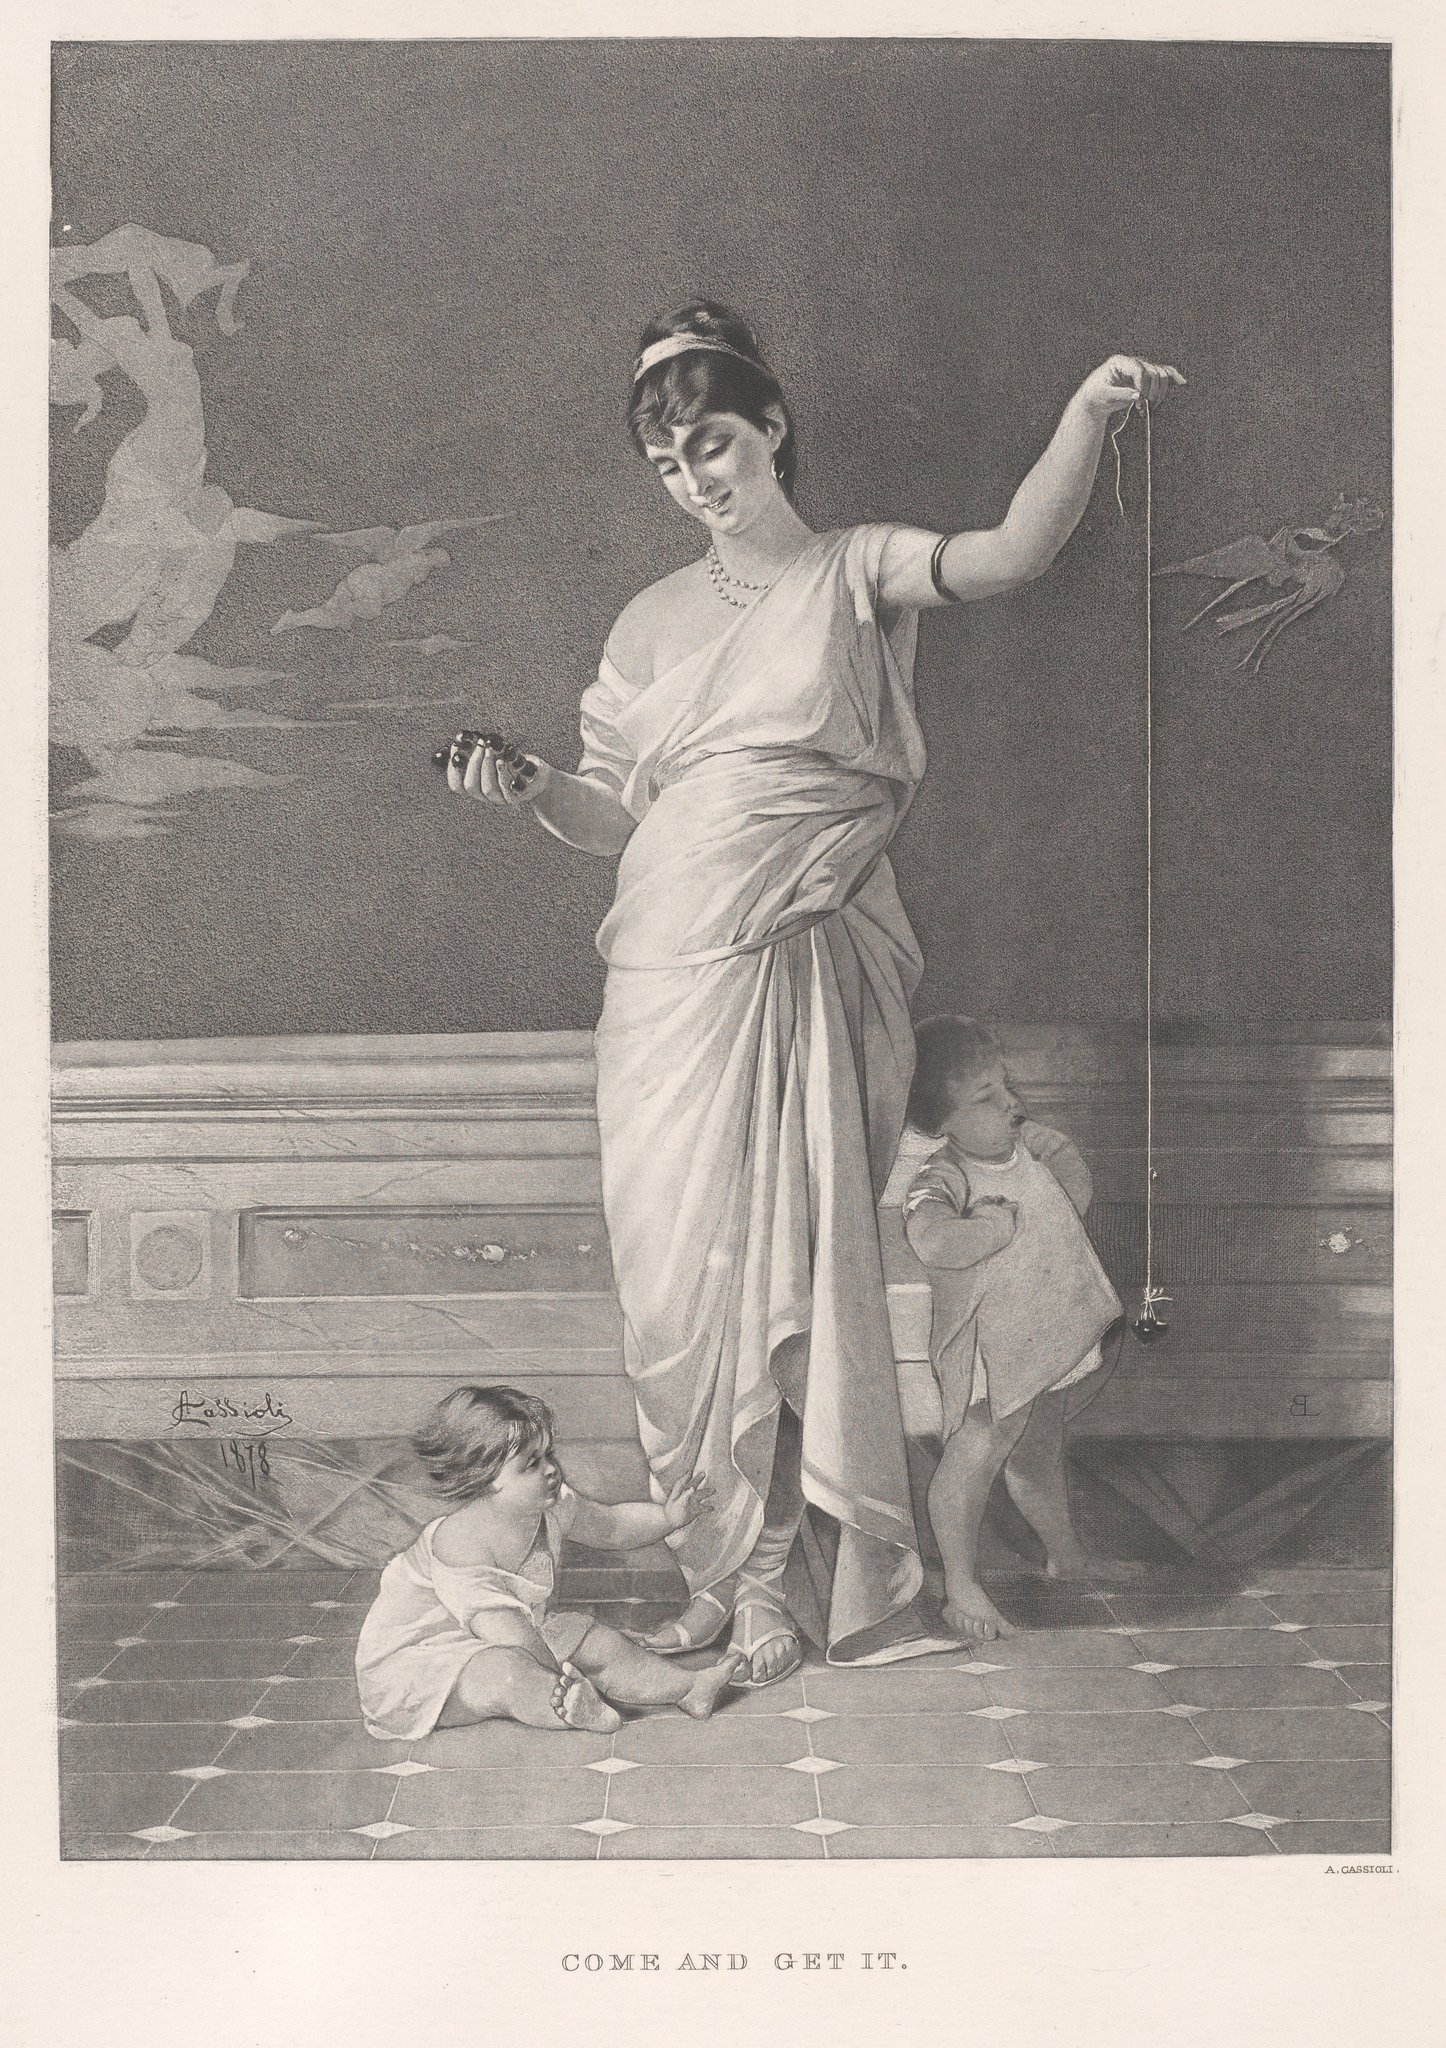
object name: print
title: Come and Get It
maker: amos cassioli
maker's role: artist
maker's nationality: italian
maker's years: 1832-1891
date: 1878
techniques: lithograph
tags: children,women